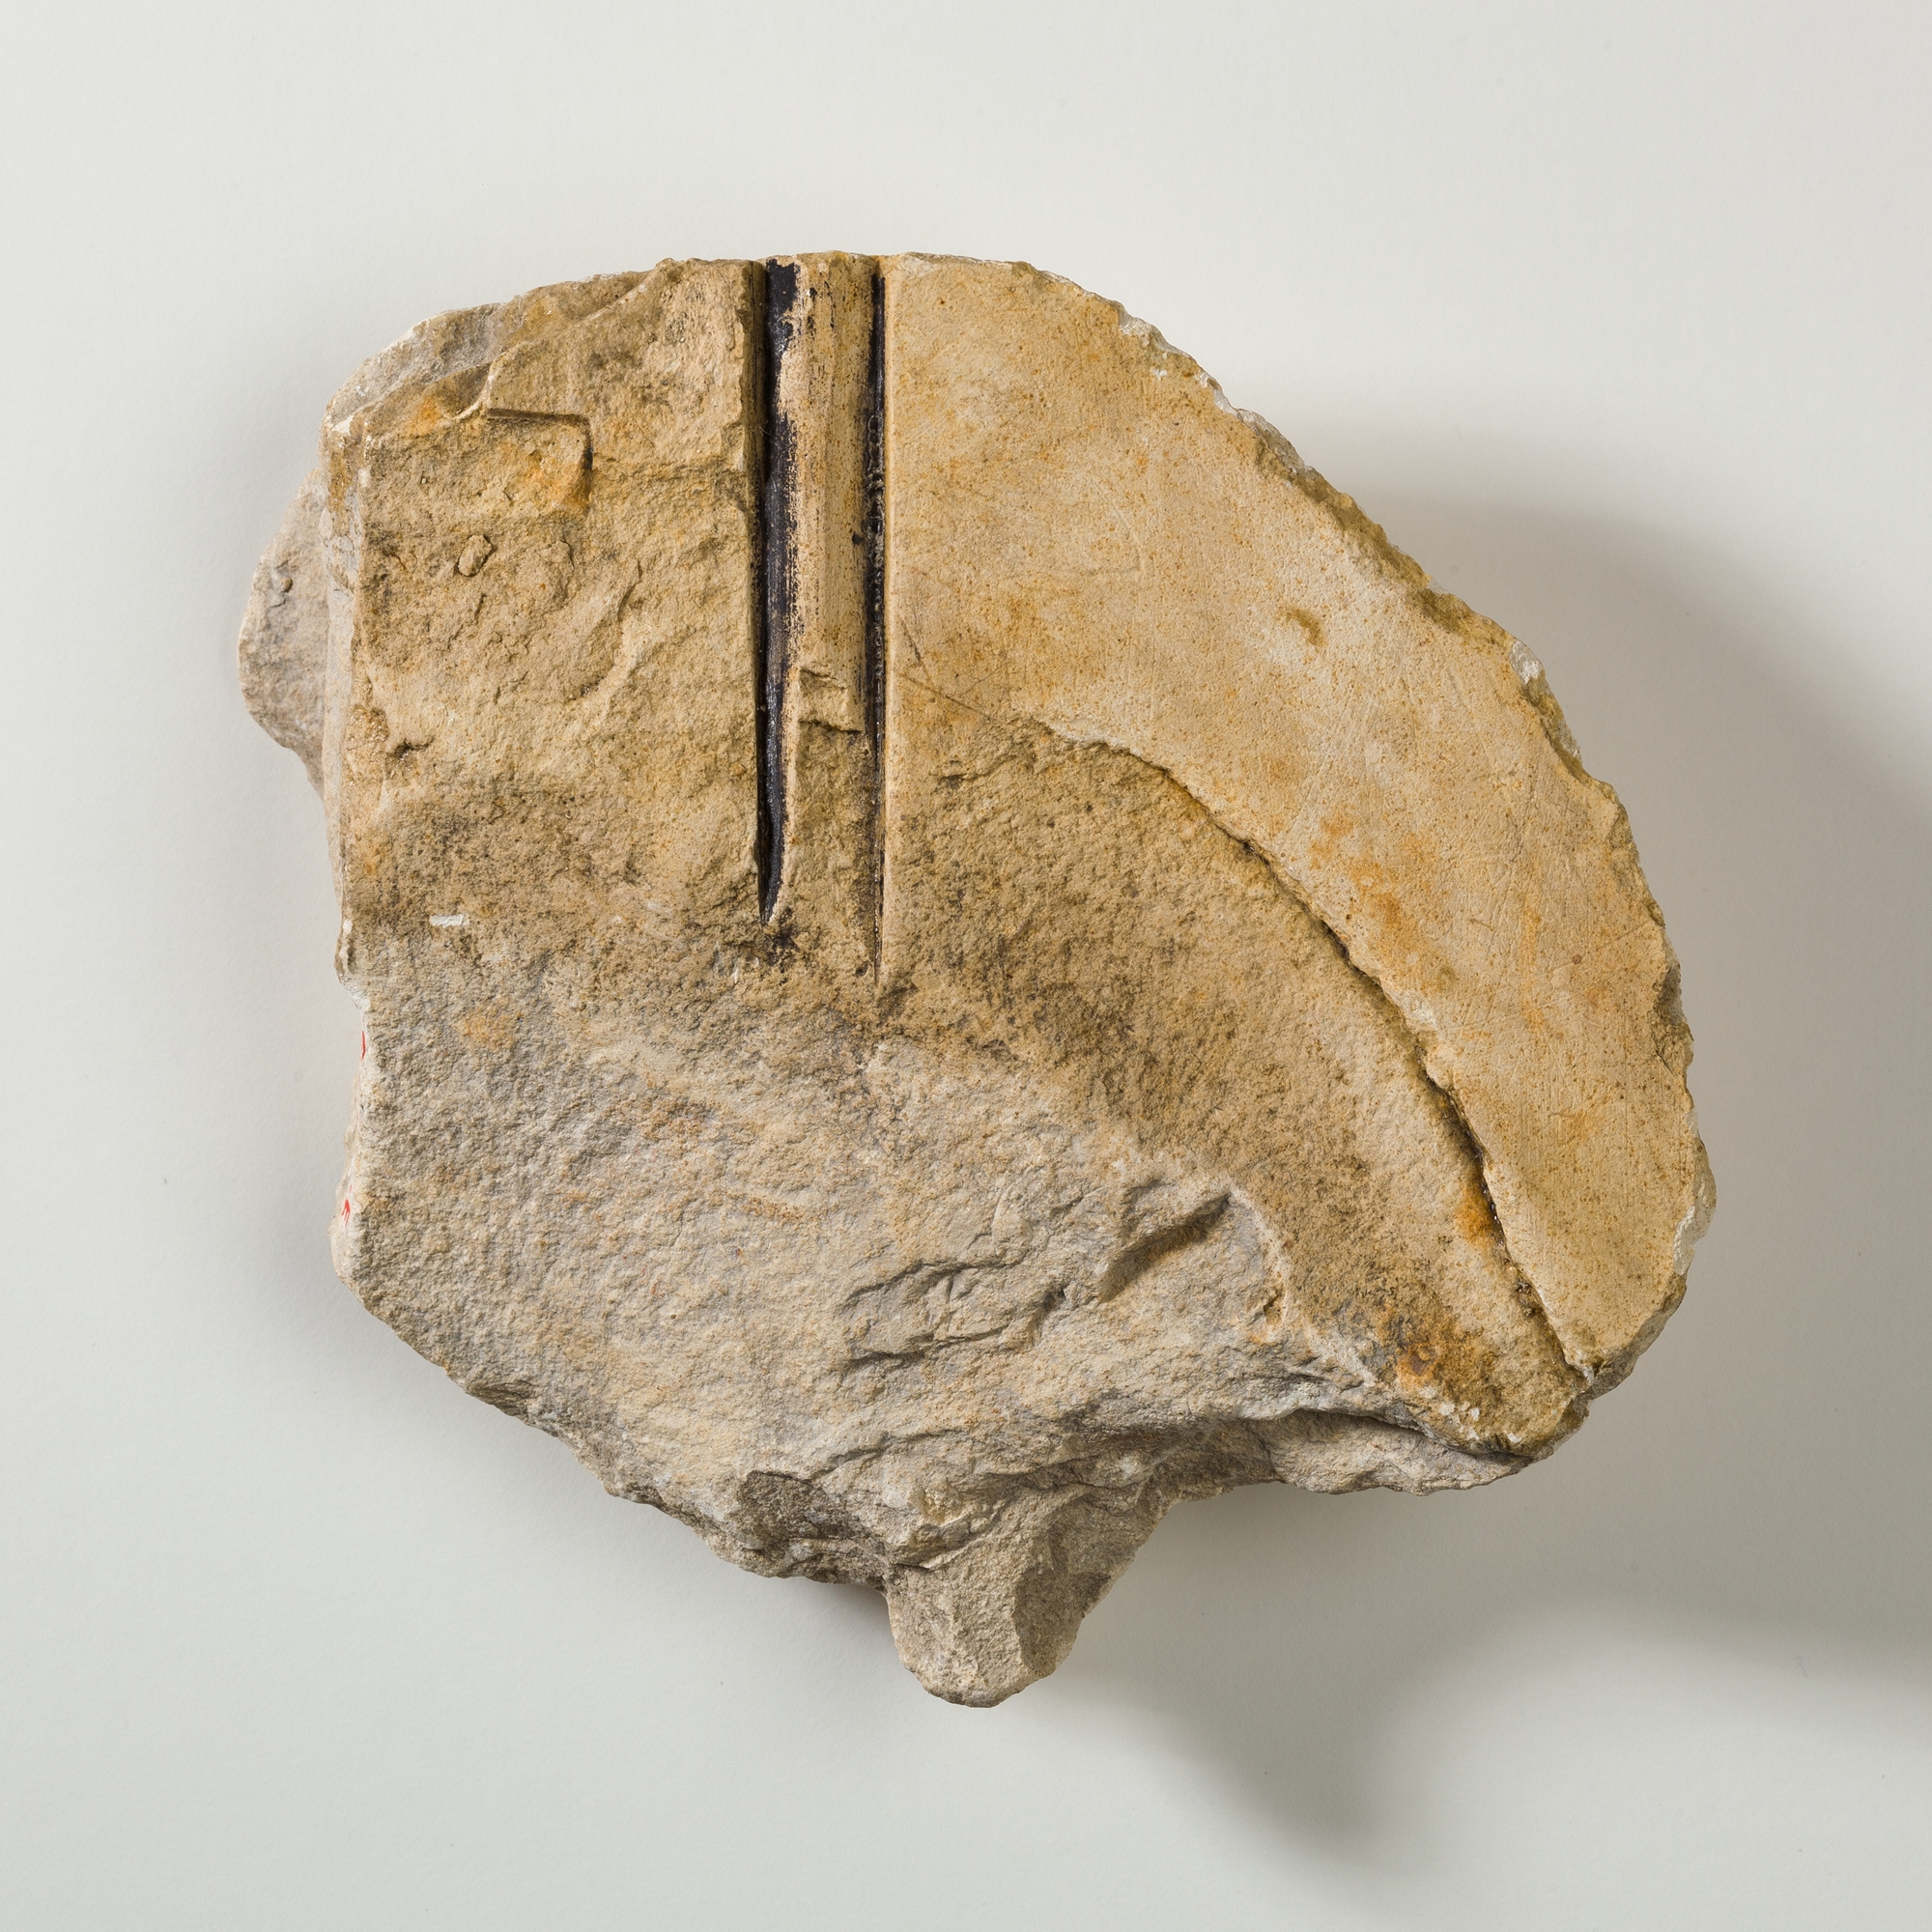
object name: relief fragment, neferu or khety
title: Relief Fragment from the Tomb of Neferu or Khety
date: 2030-1640 BCE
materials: limestone, paint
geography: egypt